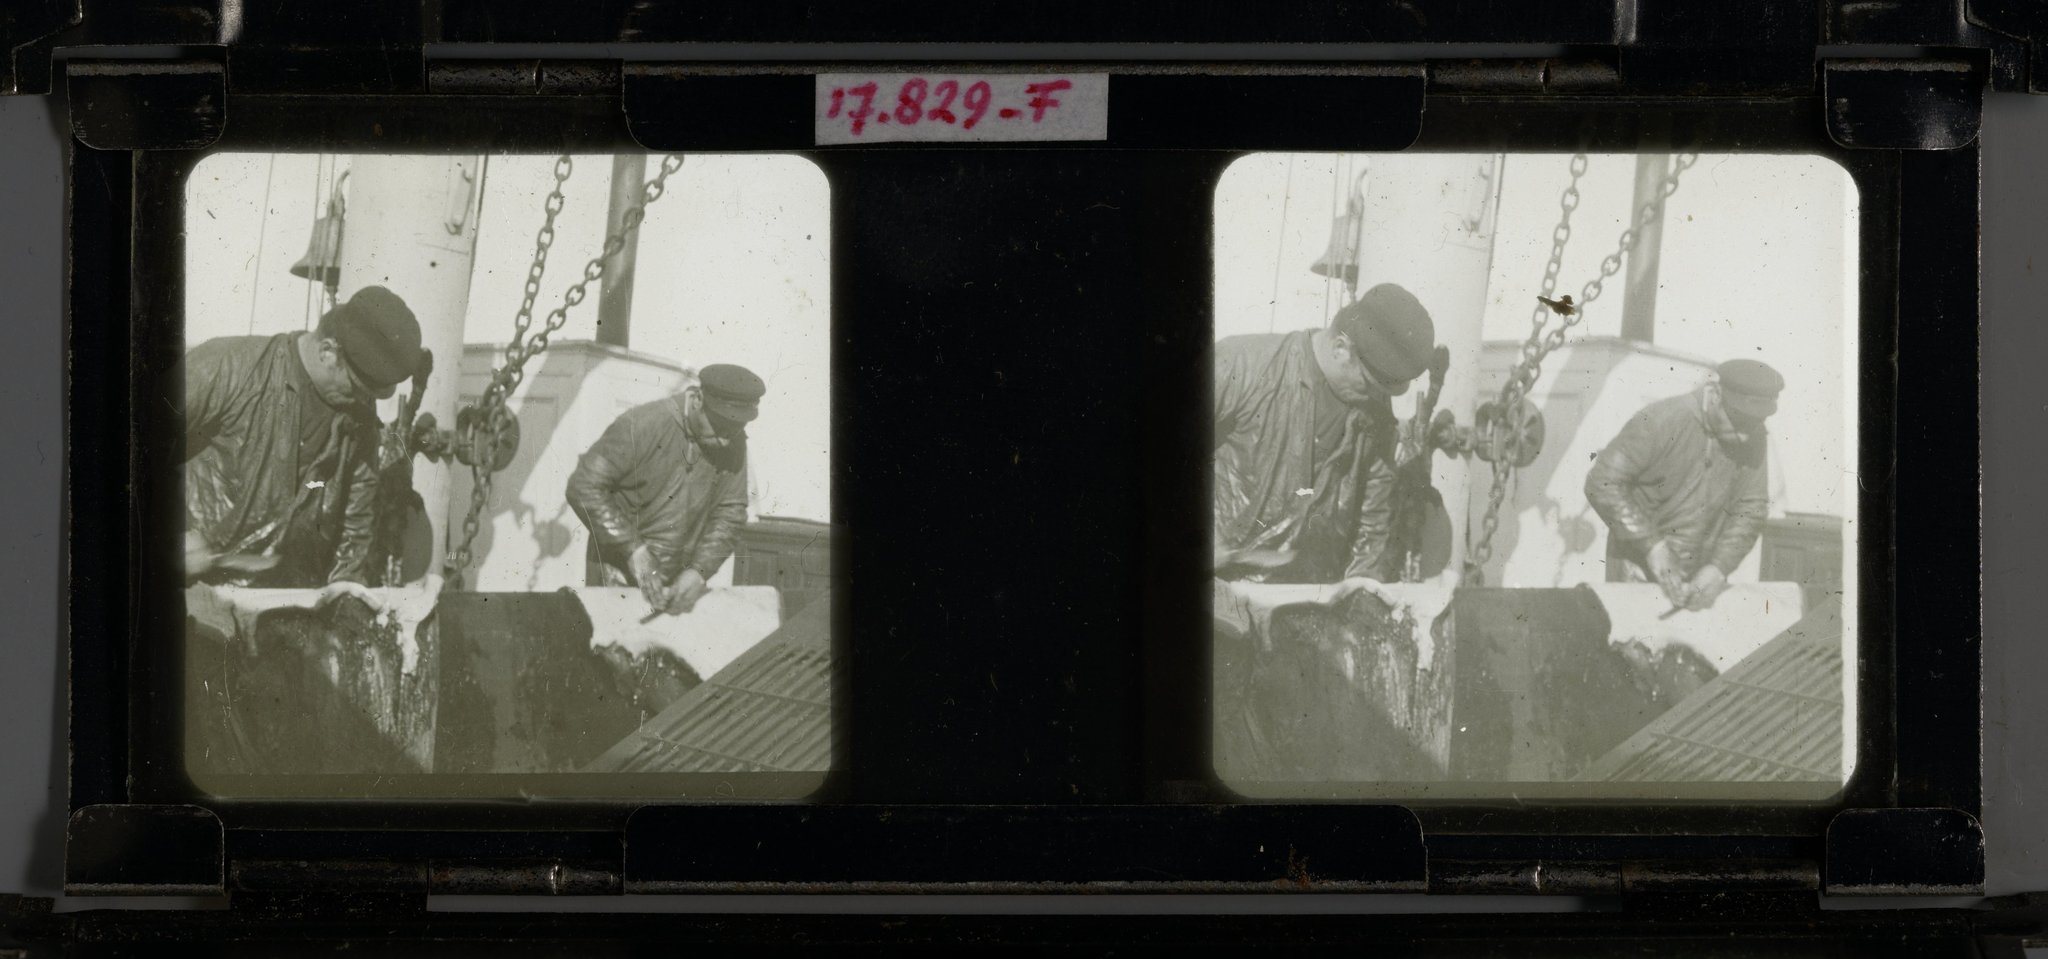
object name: stereoscopic photograph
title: Mannen maken huiden schoon op het dek van een schip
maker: Anonymous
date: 1893-1923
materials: glass, metal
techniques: slide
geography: paris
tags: crew ~ ship